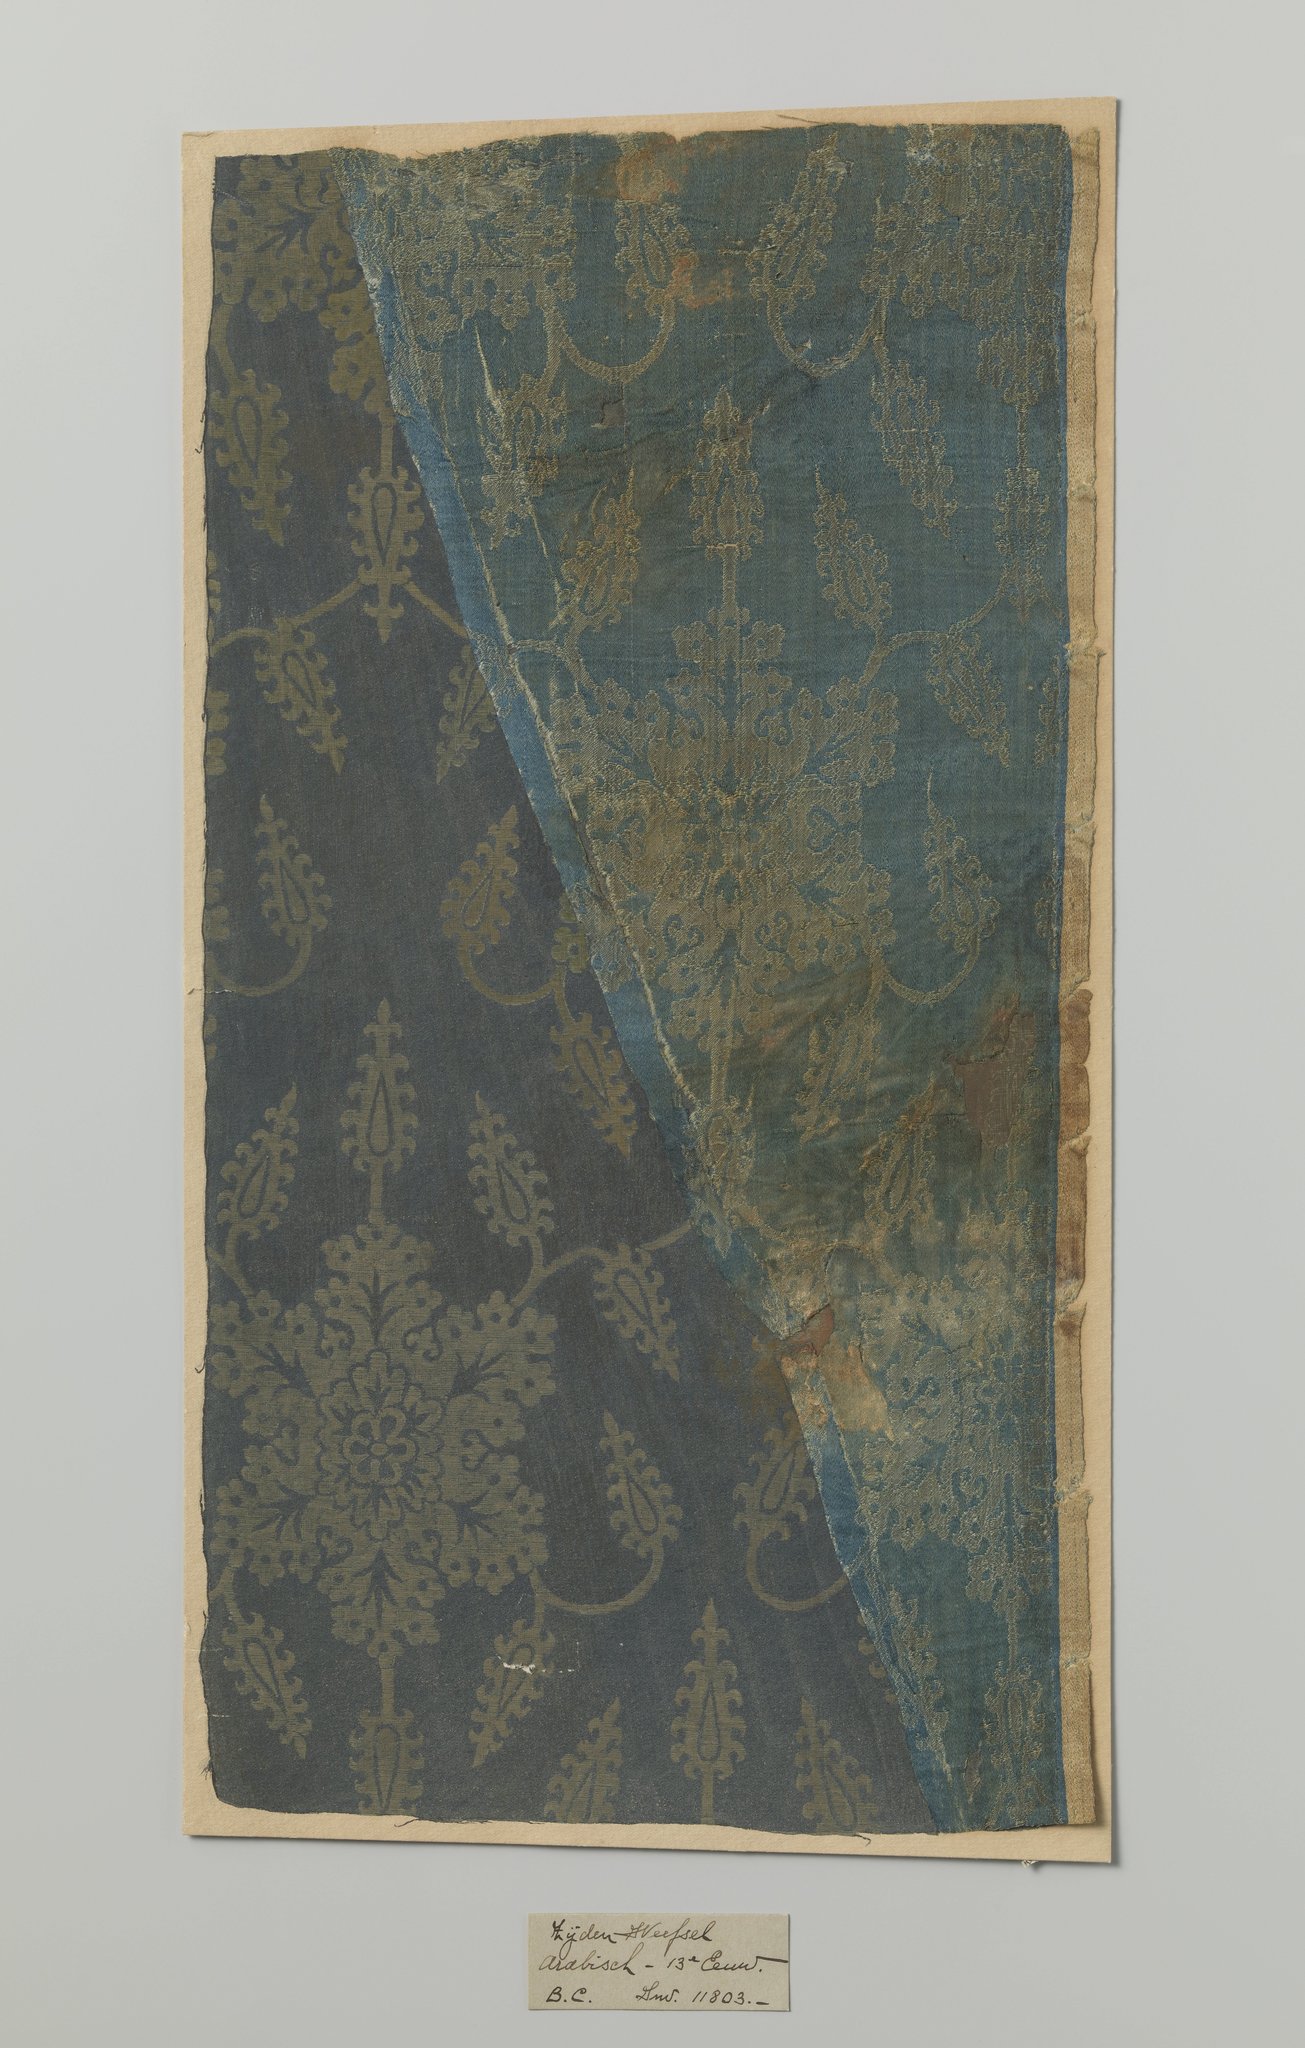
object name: zijdesatijn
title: Fragment zijdesatijn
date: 1100-1130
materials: silk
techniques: launching, satin binding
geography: arabië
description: Fragment blauwe zijde met patroon in geel van door bladwerk gevormde rozetten met elkaar verbonden door slingerende bladranken. Patroon is bijgetekend.